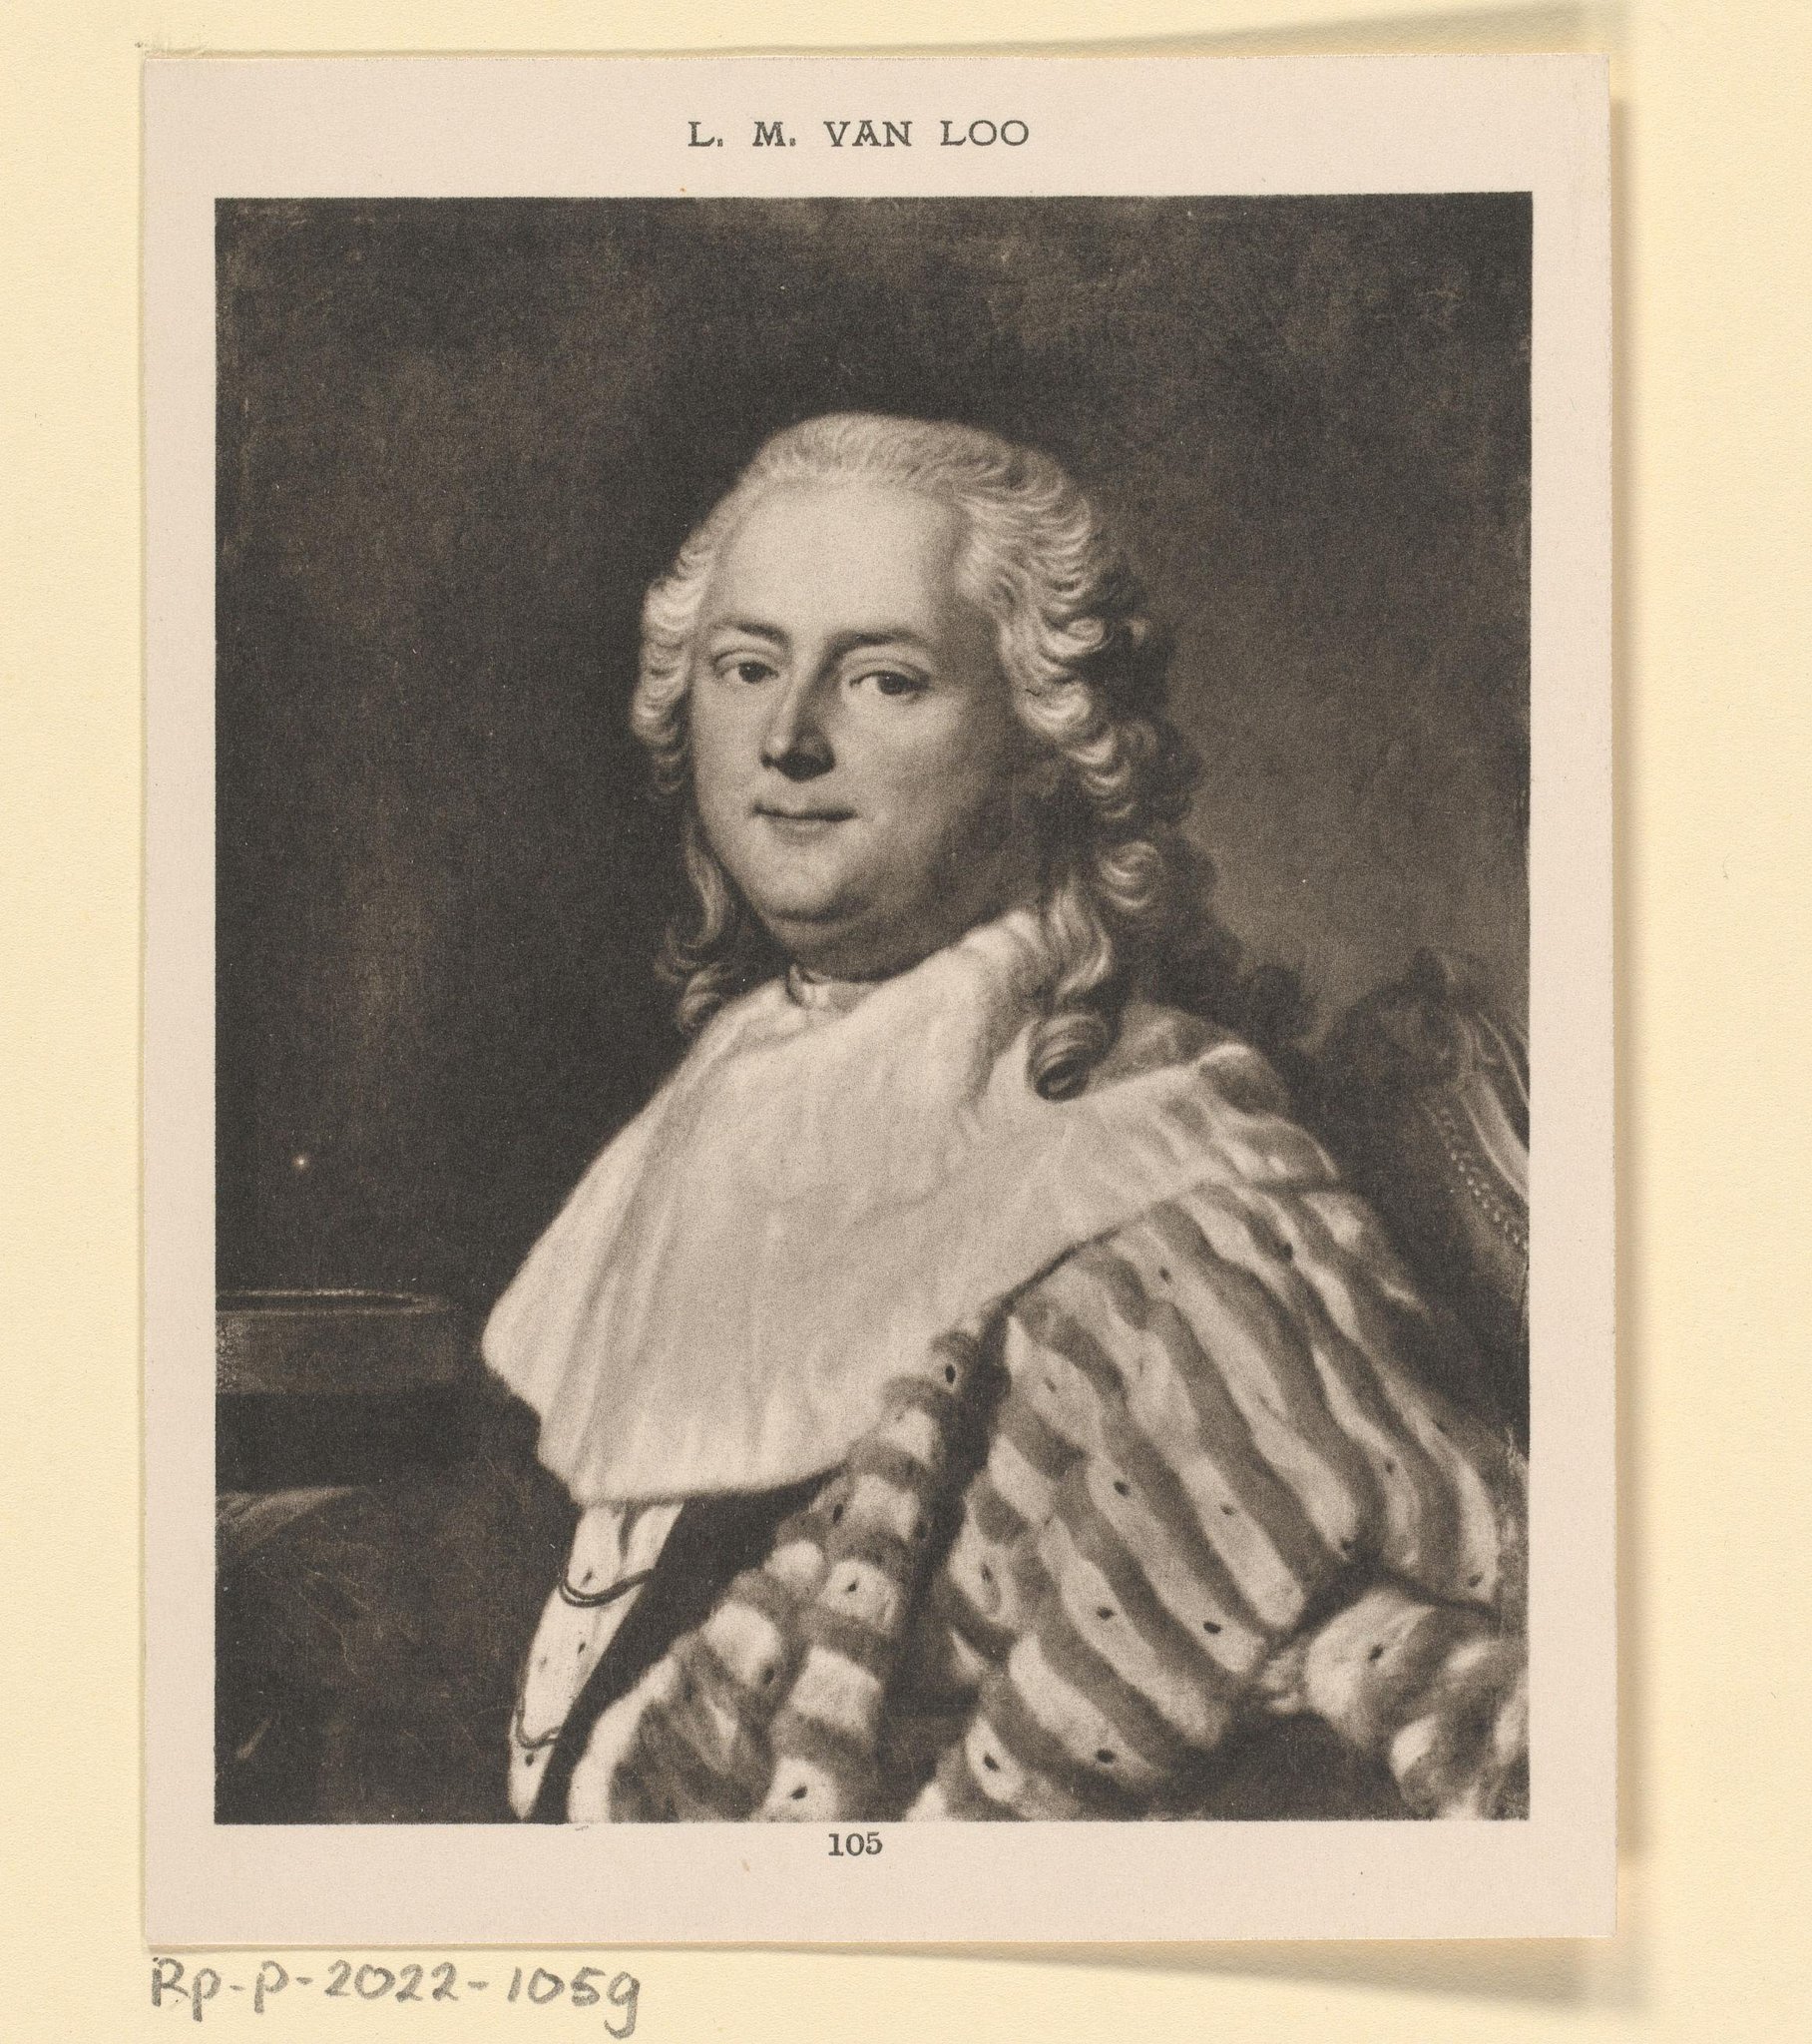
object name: photomechanical print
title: Portret van Armand Thomas Hue de Miromesnil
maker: Anonymous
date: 1875-1930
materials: paper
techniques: photograph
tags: historical persons